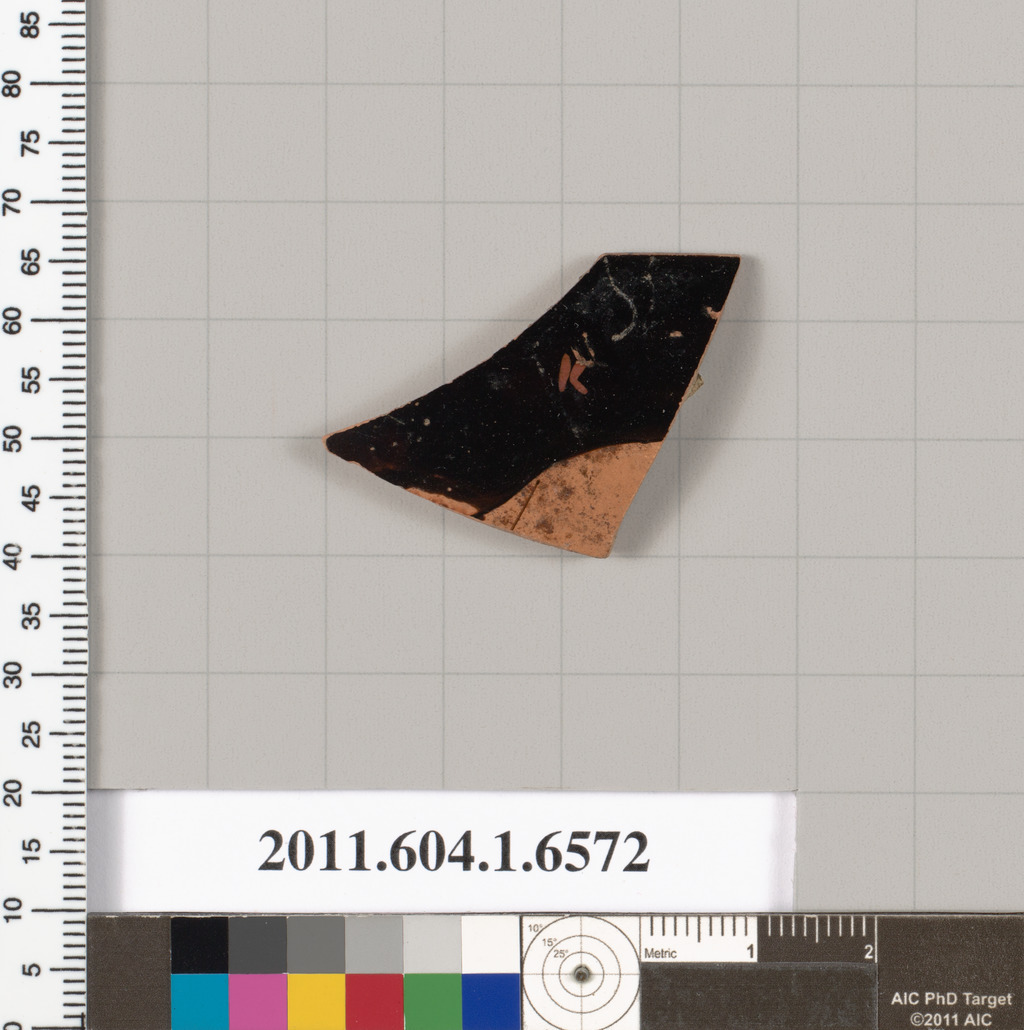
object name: kylix fragment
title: Terracotta rim fragment of a kylix (drinking cup)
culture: greek, attic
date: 490-480 BCE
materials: terracotta